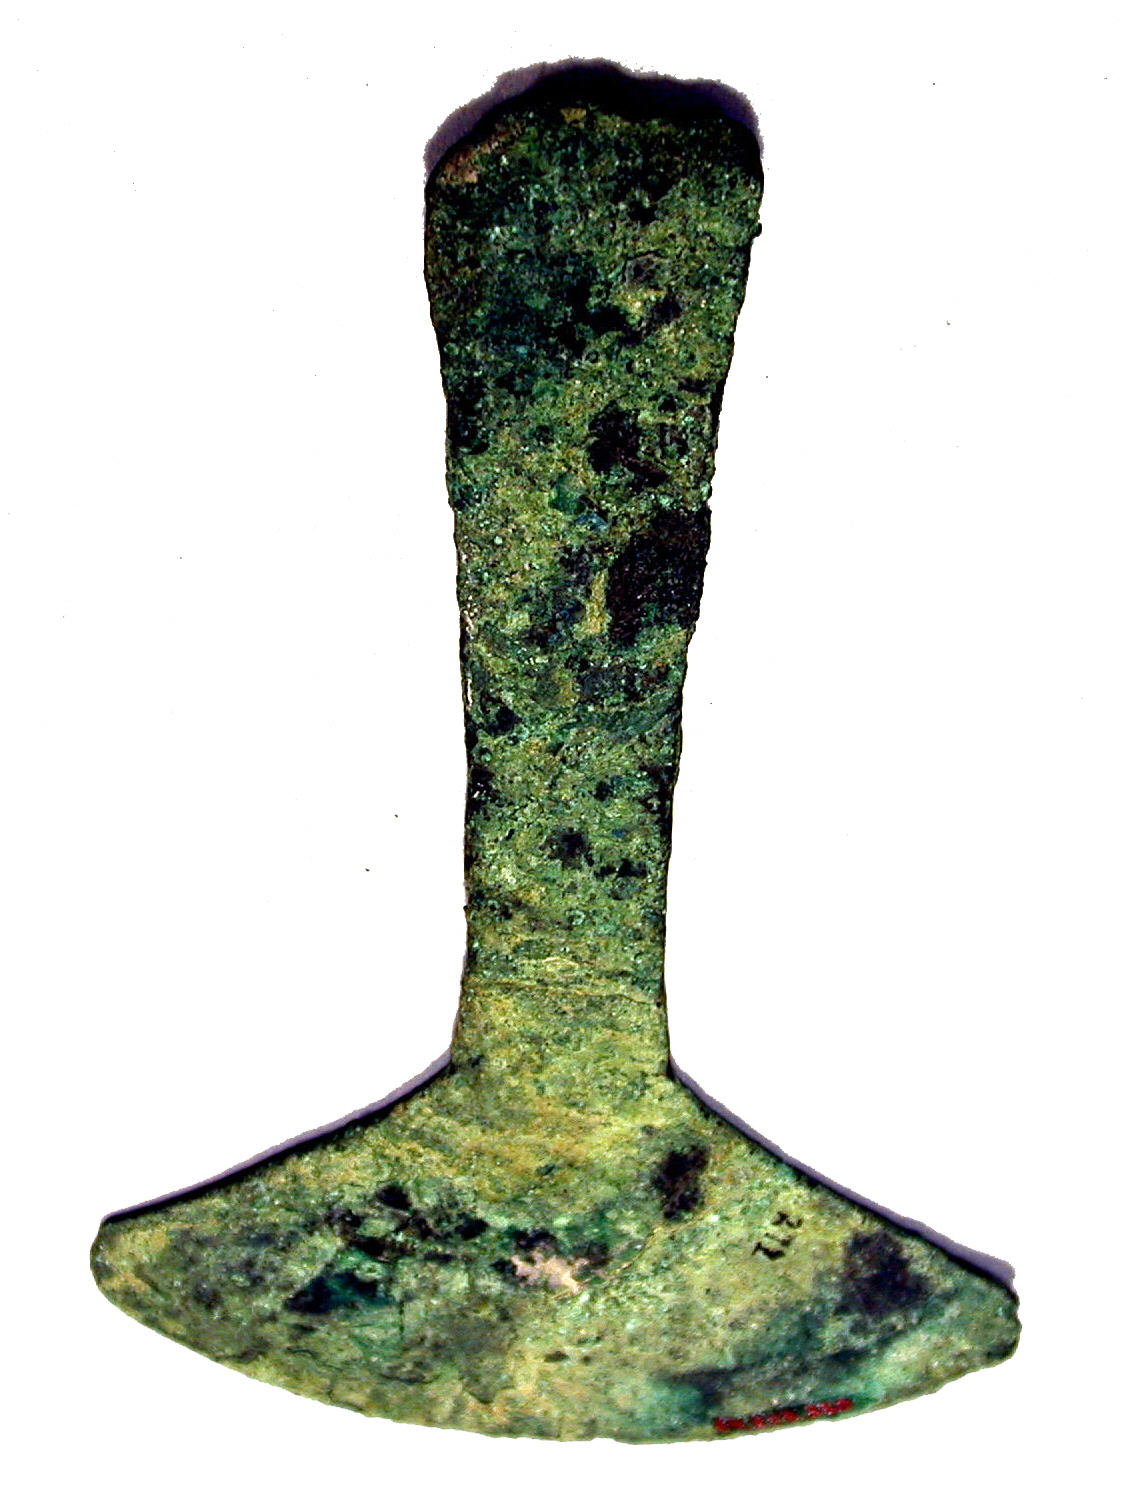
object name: knife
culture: moche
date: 1-766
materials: copper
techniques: hammering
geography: peru